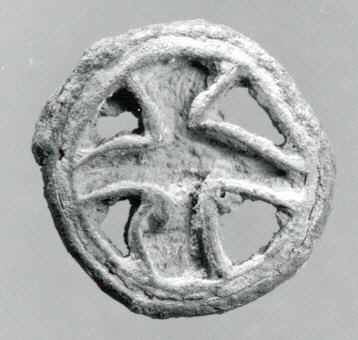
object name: stamp seal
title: Compartmented stamp seal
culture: bactria-margiana archaeological complex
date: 2333-1668 BCE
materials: copper alloy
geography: bactria-margiana